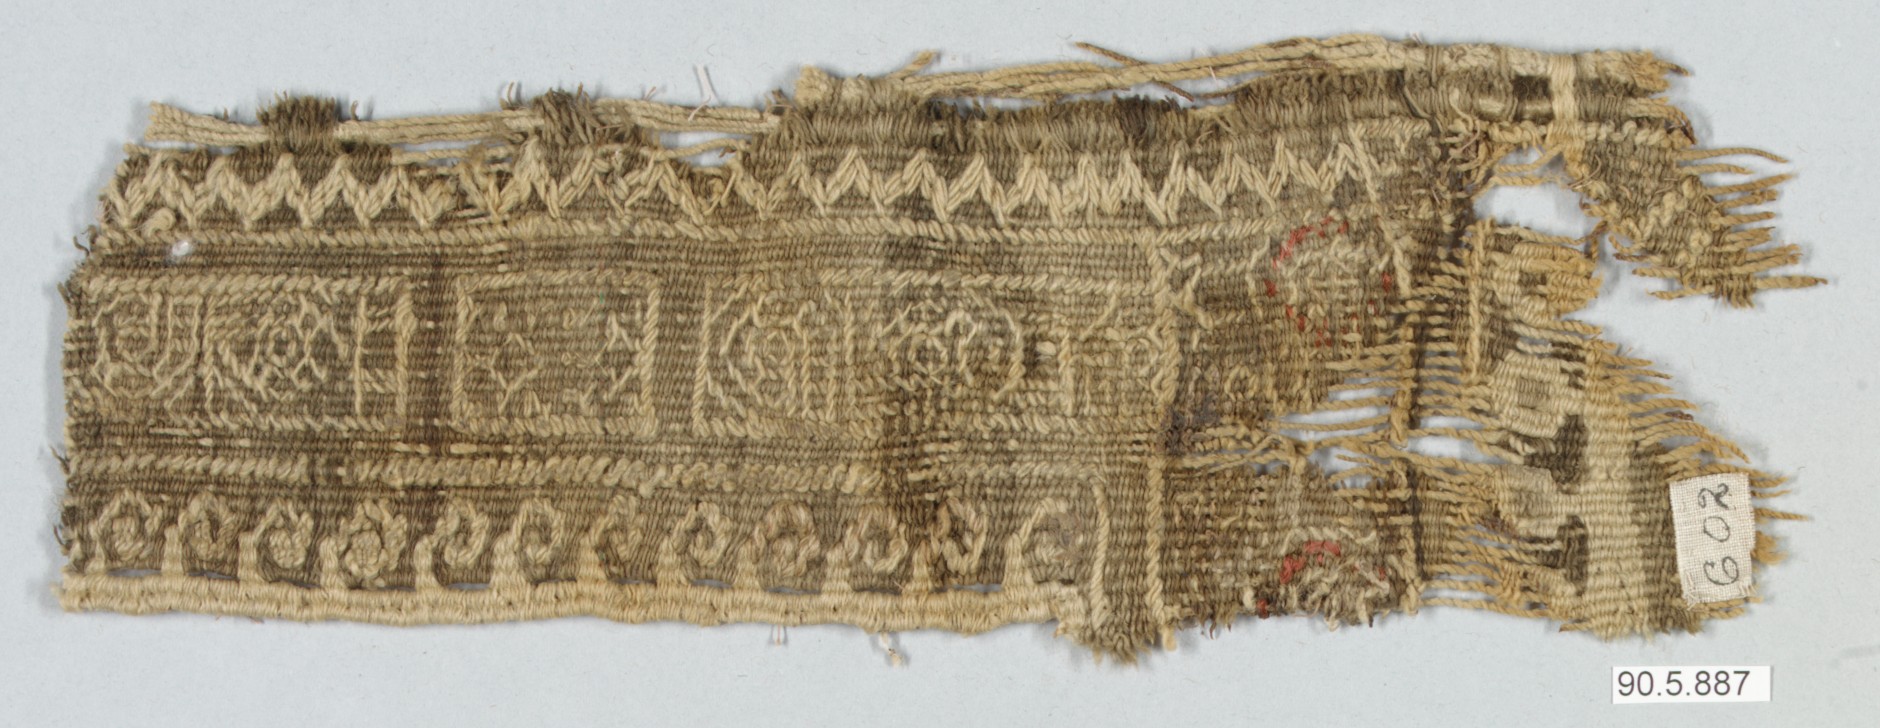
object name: textile fragment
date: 401-600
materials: wool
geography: egypt